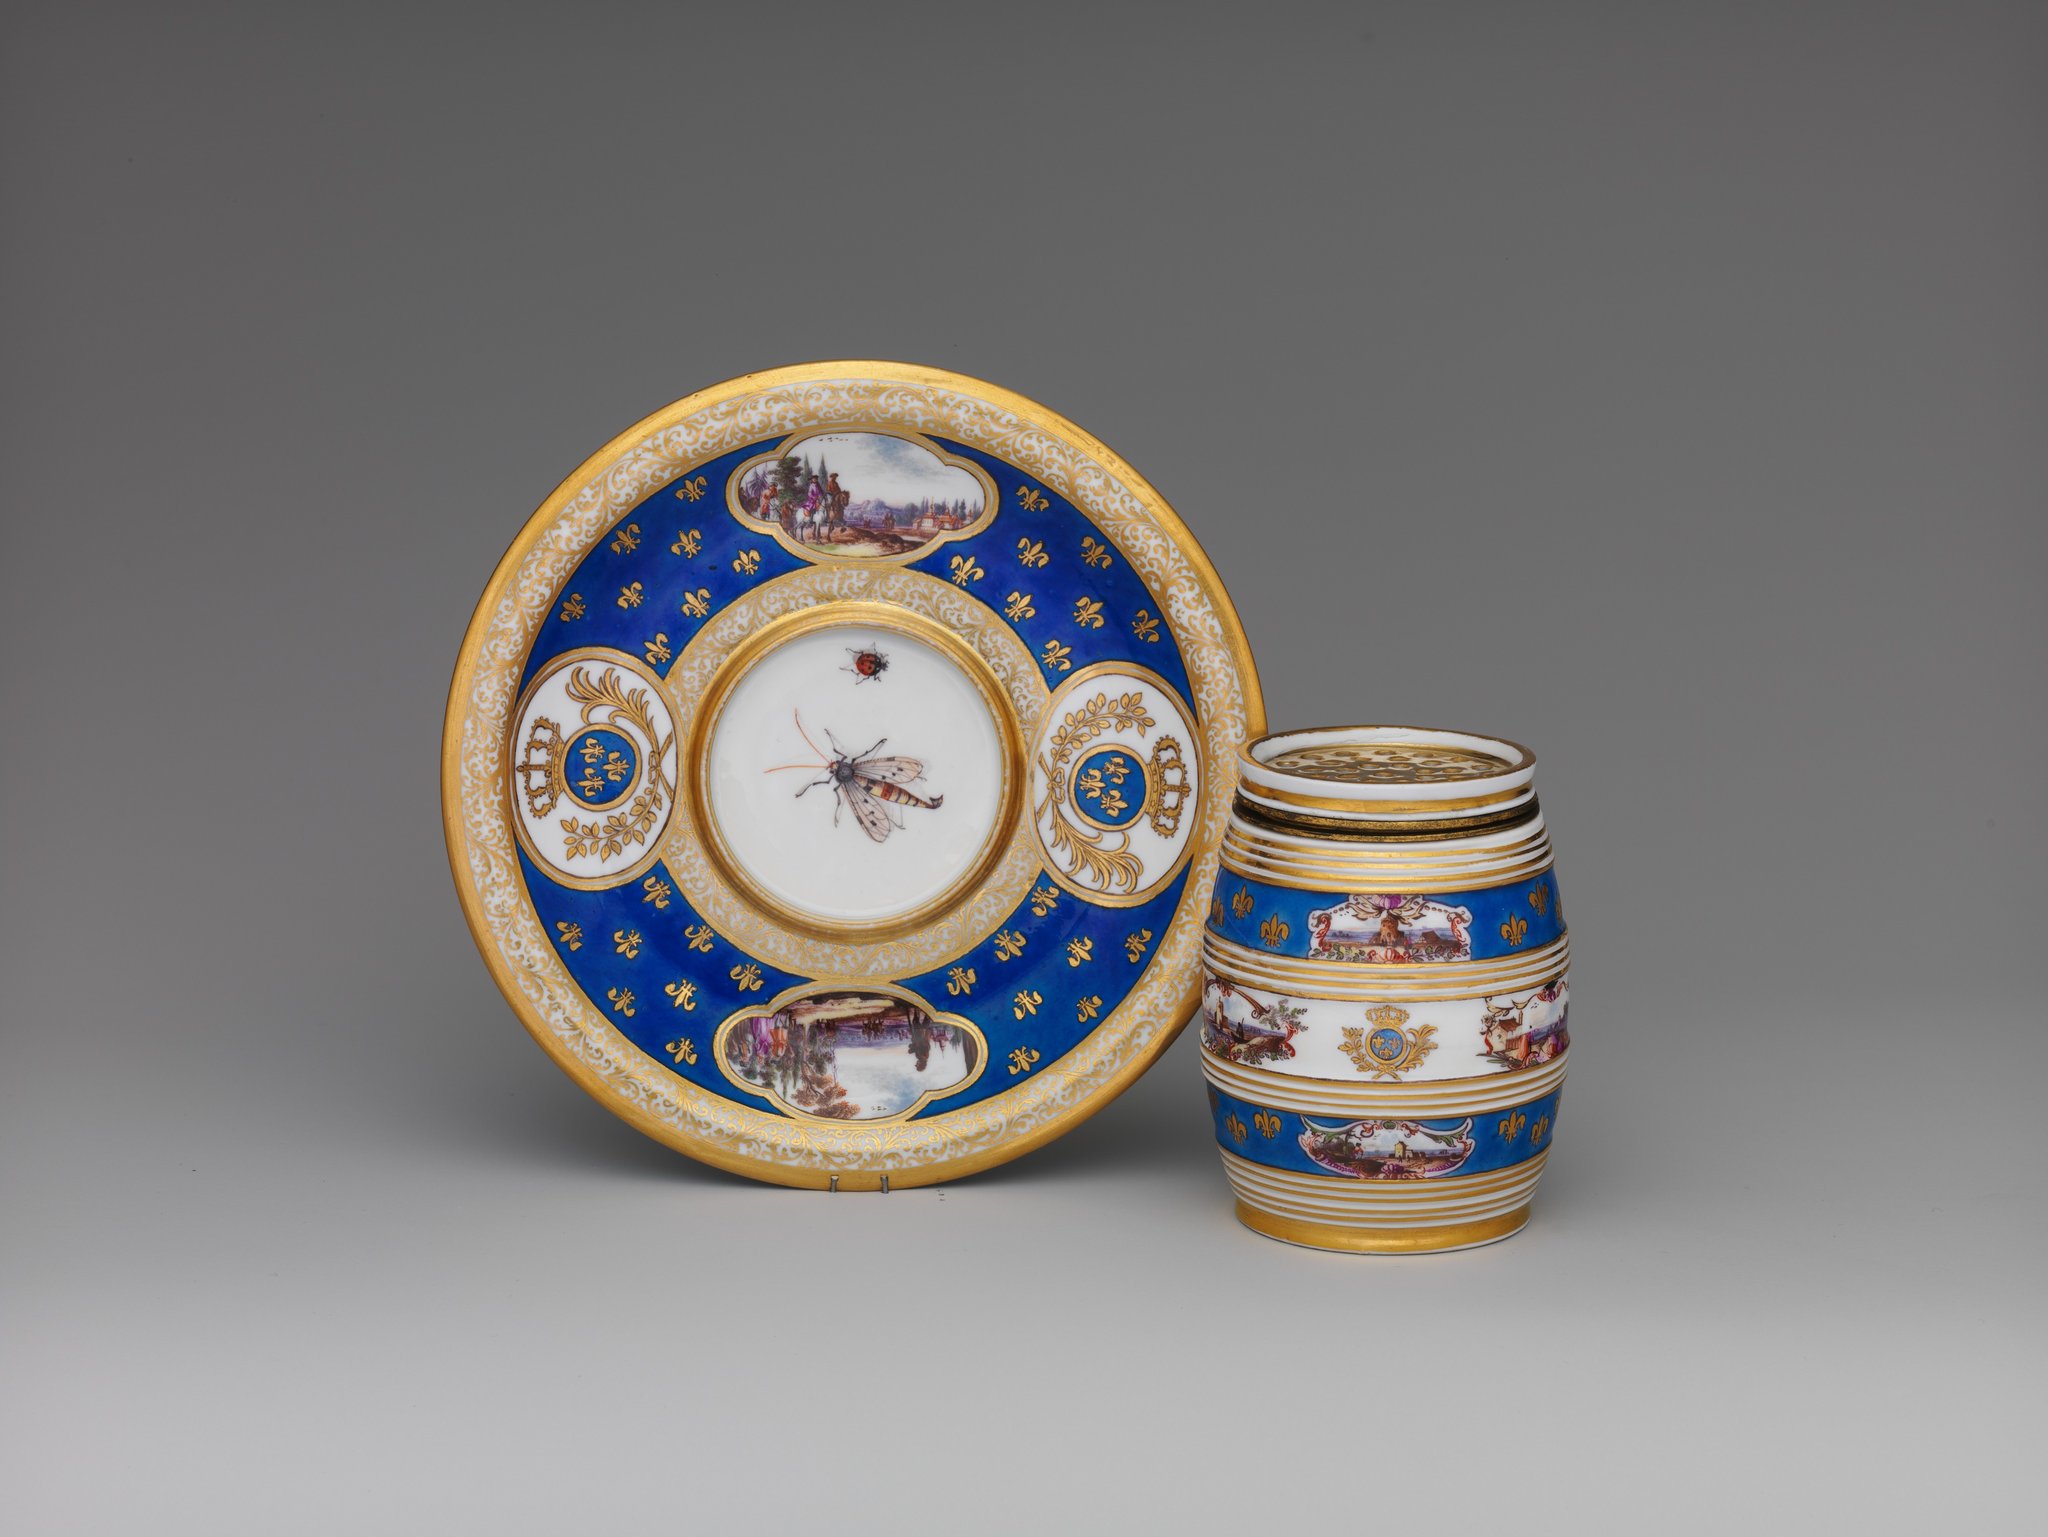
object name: tray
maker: meissen manufactory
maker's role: manufactory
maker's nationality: german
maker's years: 1710-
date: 1740-1750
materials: hard paste porcelain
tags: insects,insignia